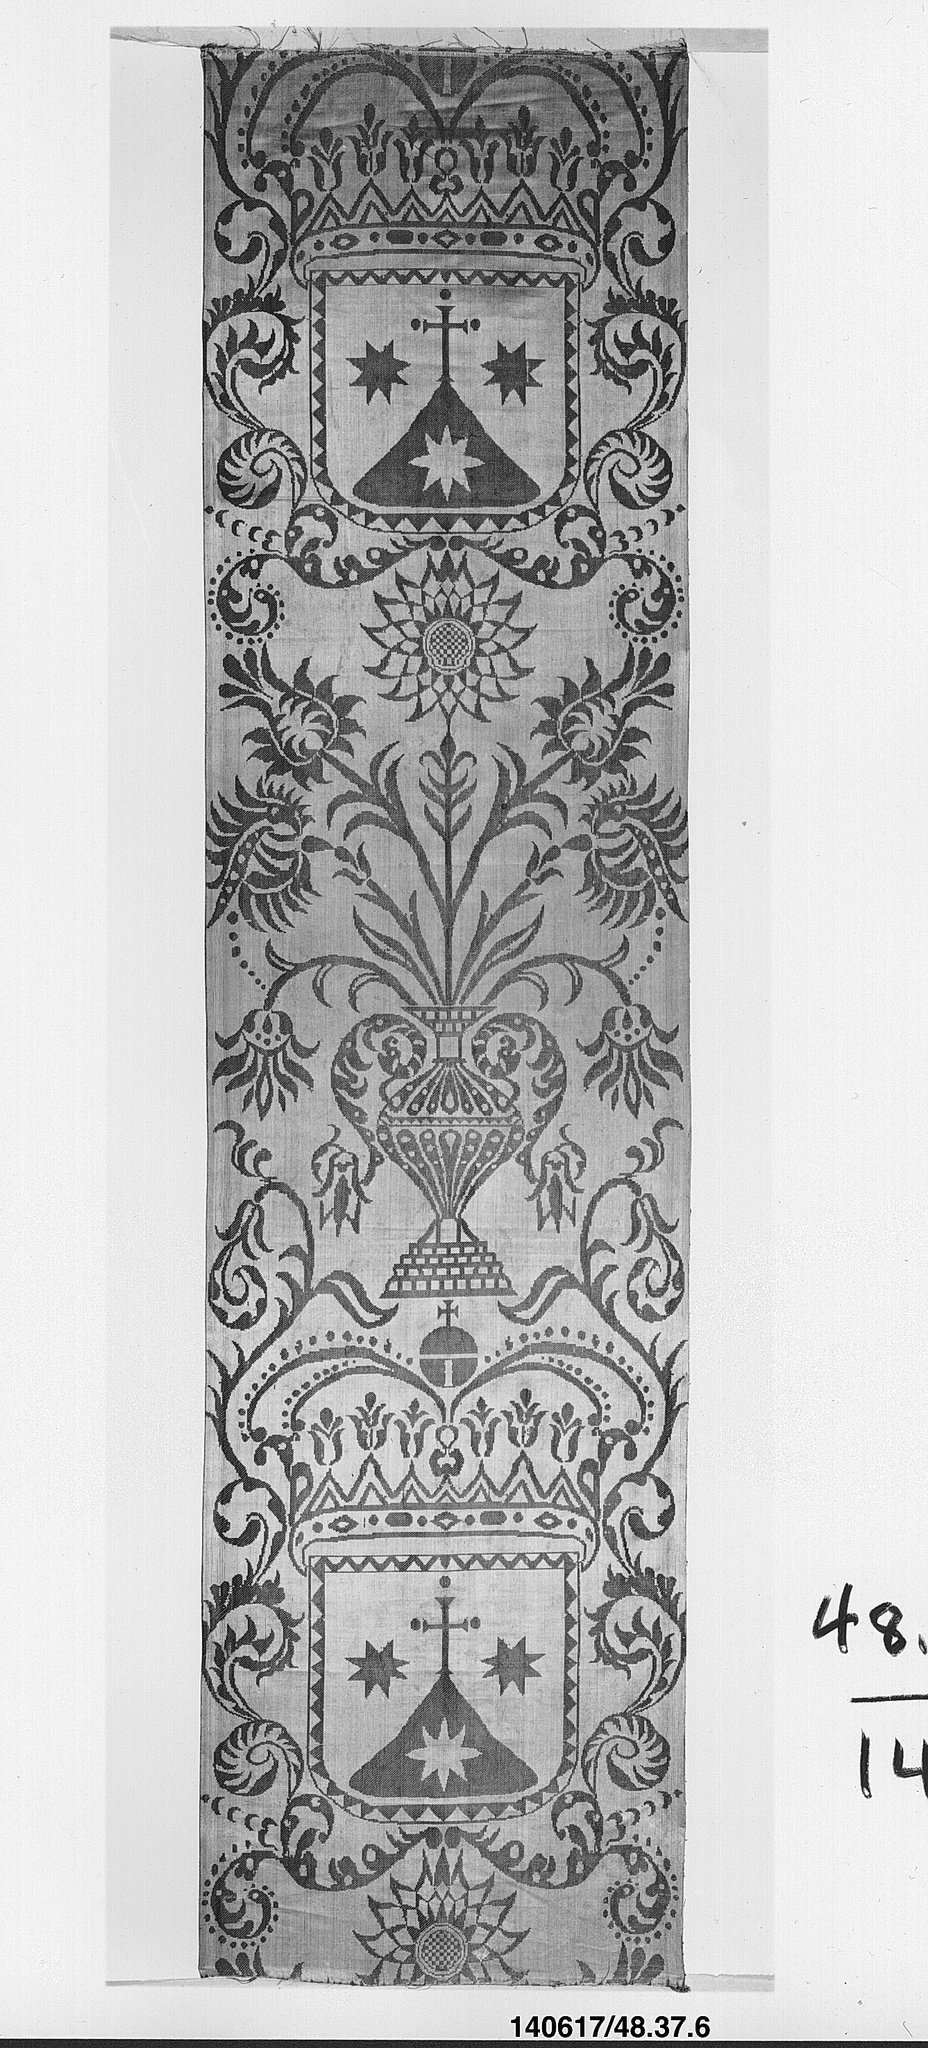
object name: panel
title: Length of silk with Carmelite Order coat-of-arms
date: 1601-1700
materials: silk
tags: coat of arms